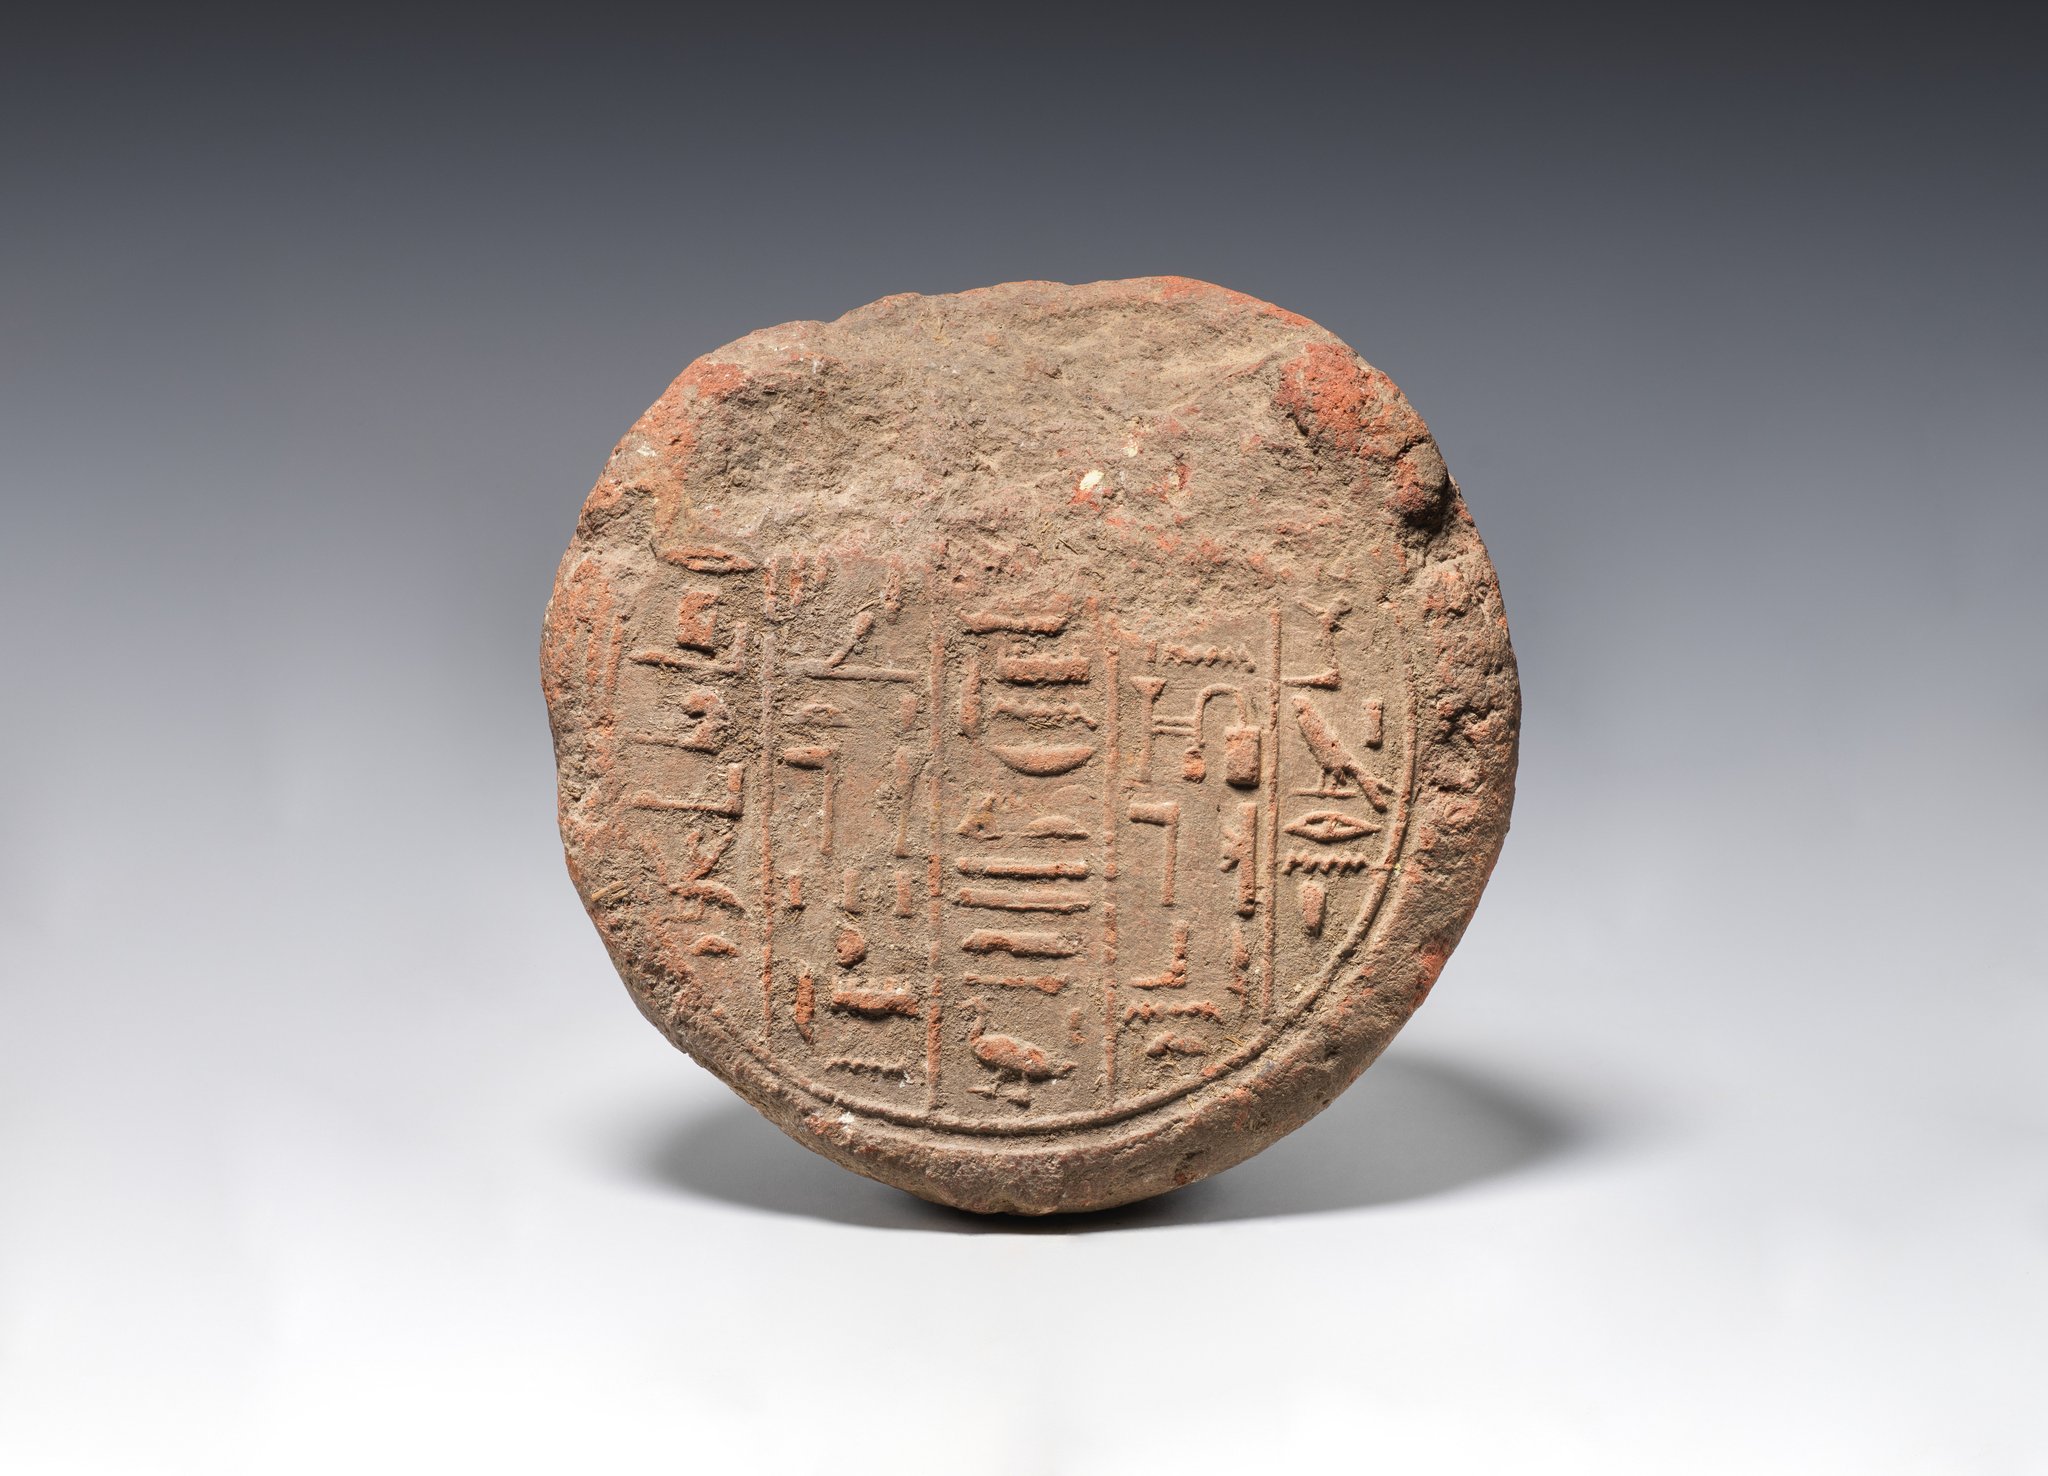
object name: cone, round, padiamunnebnesuttawy, chancellor, amun, lector, priest beniuutehhor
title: Funerary Cone Pedy-Amun-neb-nesut-towy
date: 712-525 BCE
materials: pottery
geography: egypt